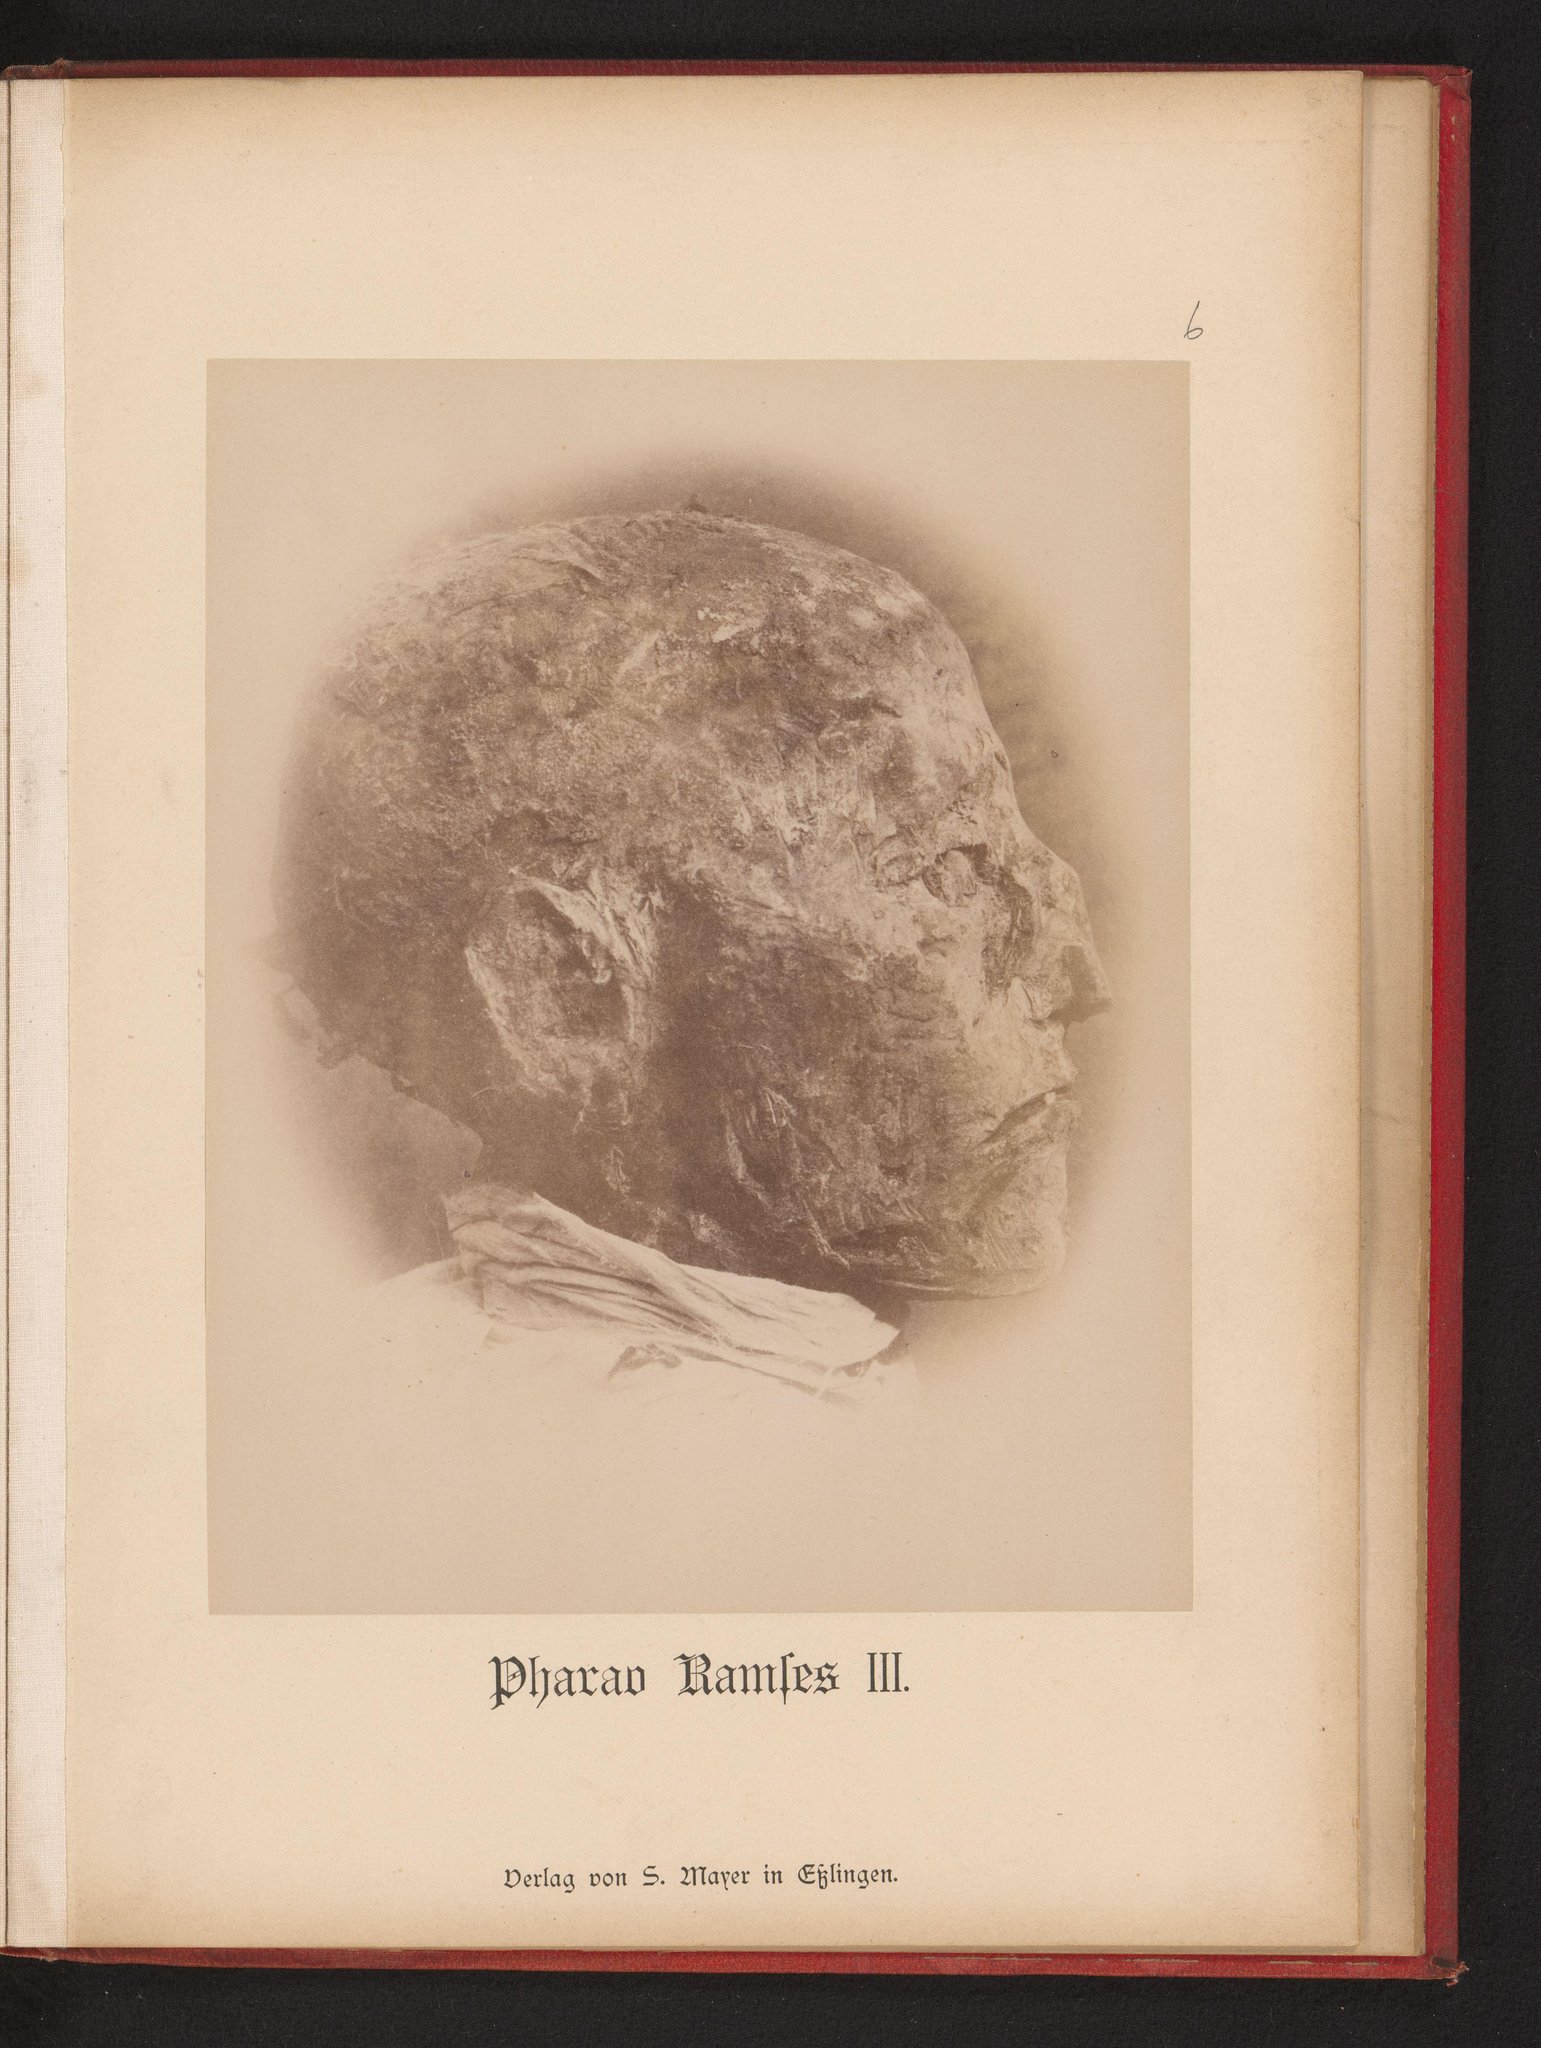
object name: photograph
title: Pharao Ramses III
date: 1881-1886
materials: photographic support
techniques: albumen print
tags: thebes, king, mummy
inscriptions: inscription: ‘Verlag von S. Mayer in Esslingen’